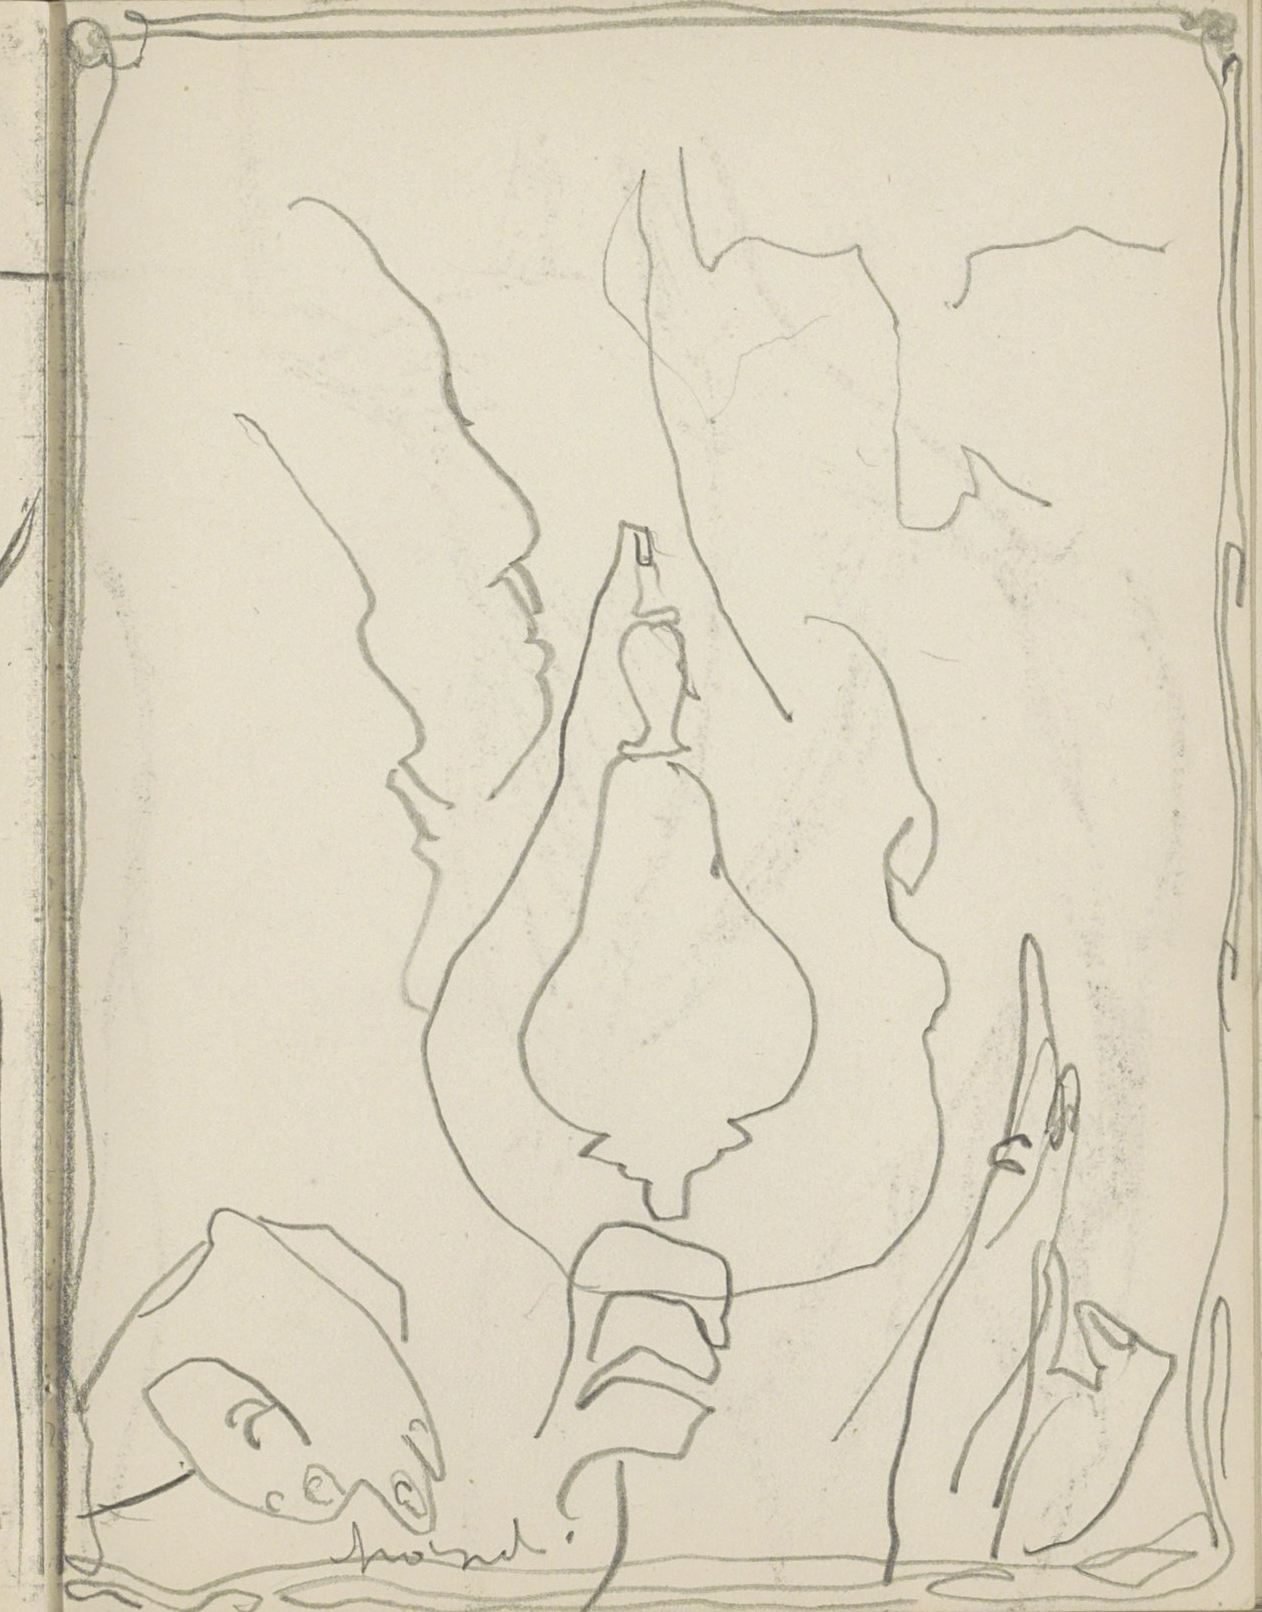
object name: sketchbook leaf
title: Studieblad, onder andere met gezichten in profiel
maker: reijer stolk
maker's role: draughtsman, print maker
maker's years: 1896-1945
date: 1906-1945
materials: paper, pencil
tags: face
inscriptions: annotation: ‘hond.’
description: Blad 44 recto uit een schetsboek met 69 bladen.